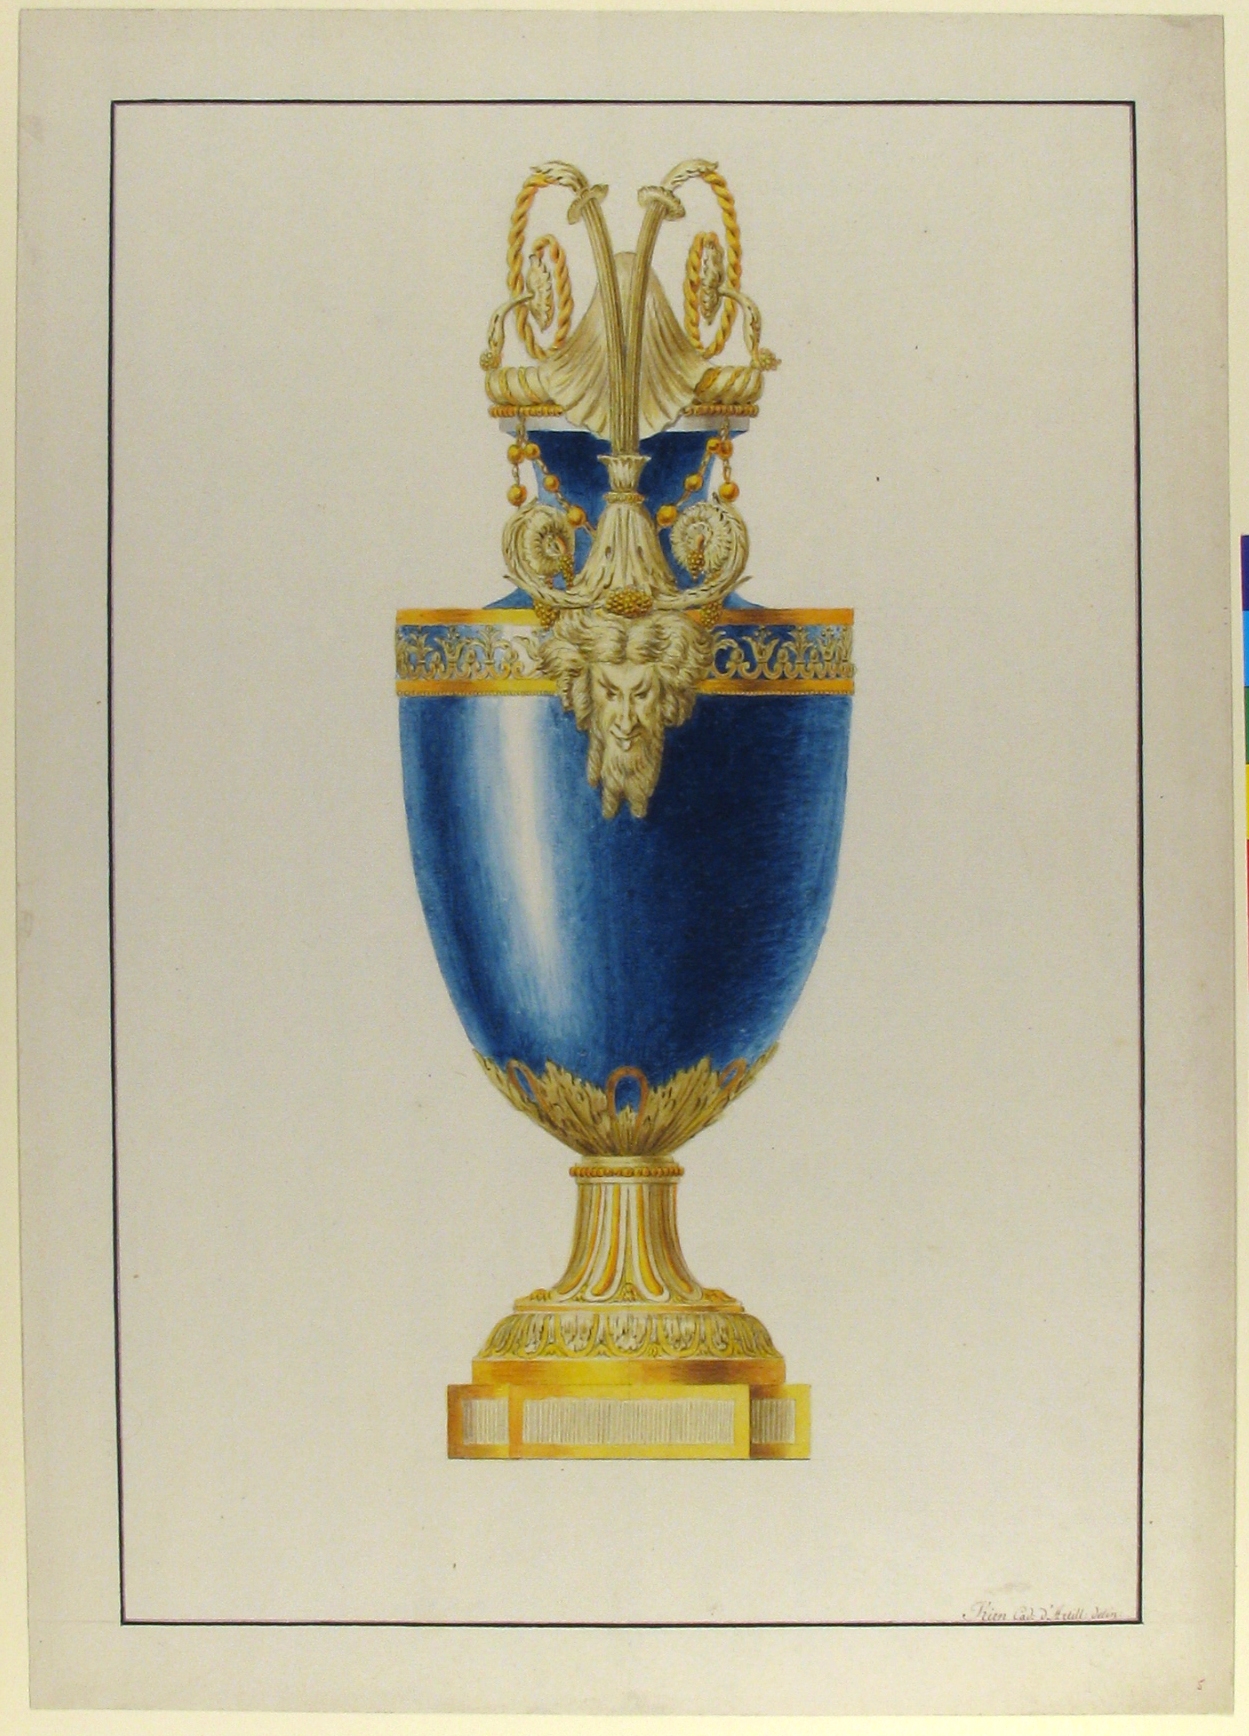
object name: drawing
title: Design for a Gilt Bronze Urn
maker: george heinrich von kirn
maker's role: artist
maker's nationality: german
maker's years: 1736-1793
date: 1770-1790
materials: graphite, ink, watercolor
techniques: pen, drawing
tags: urns